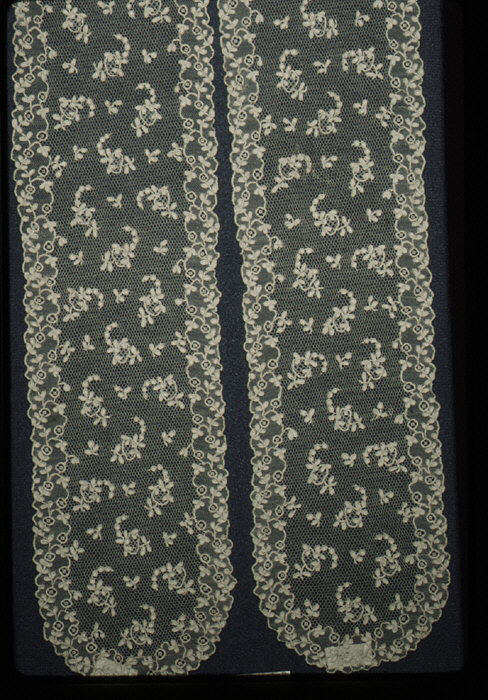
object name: lappet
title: Lappet (one of a pair)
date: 1767-1800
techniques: lace